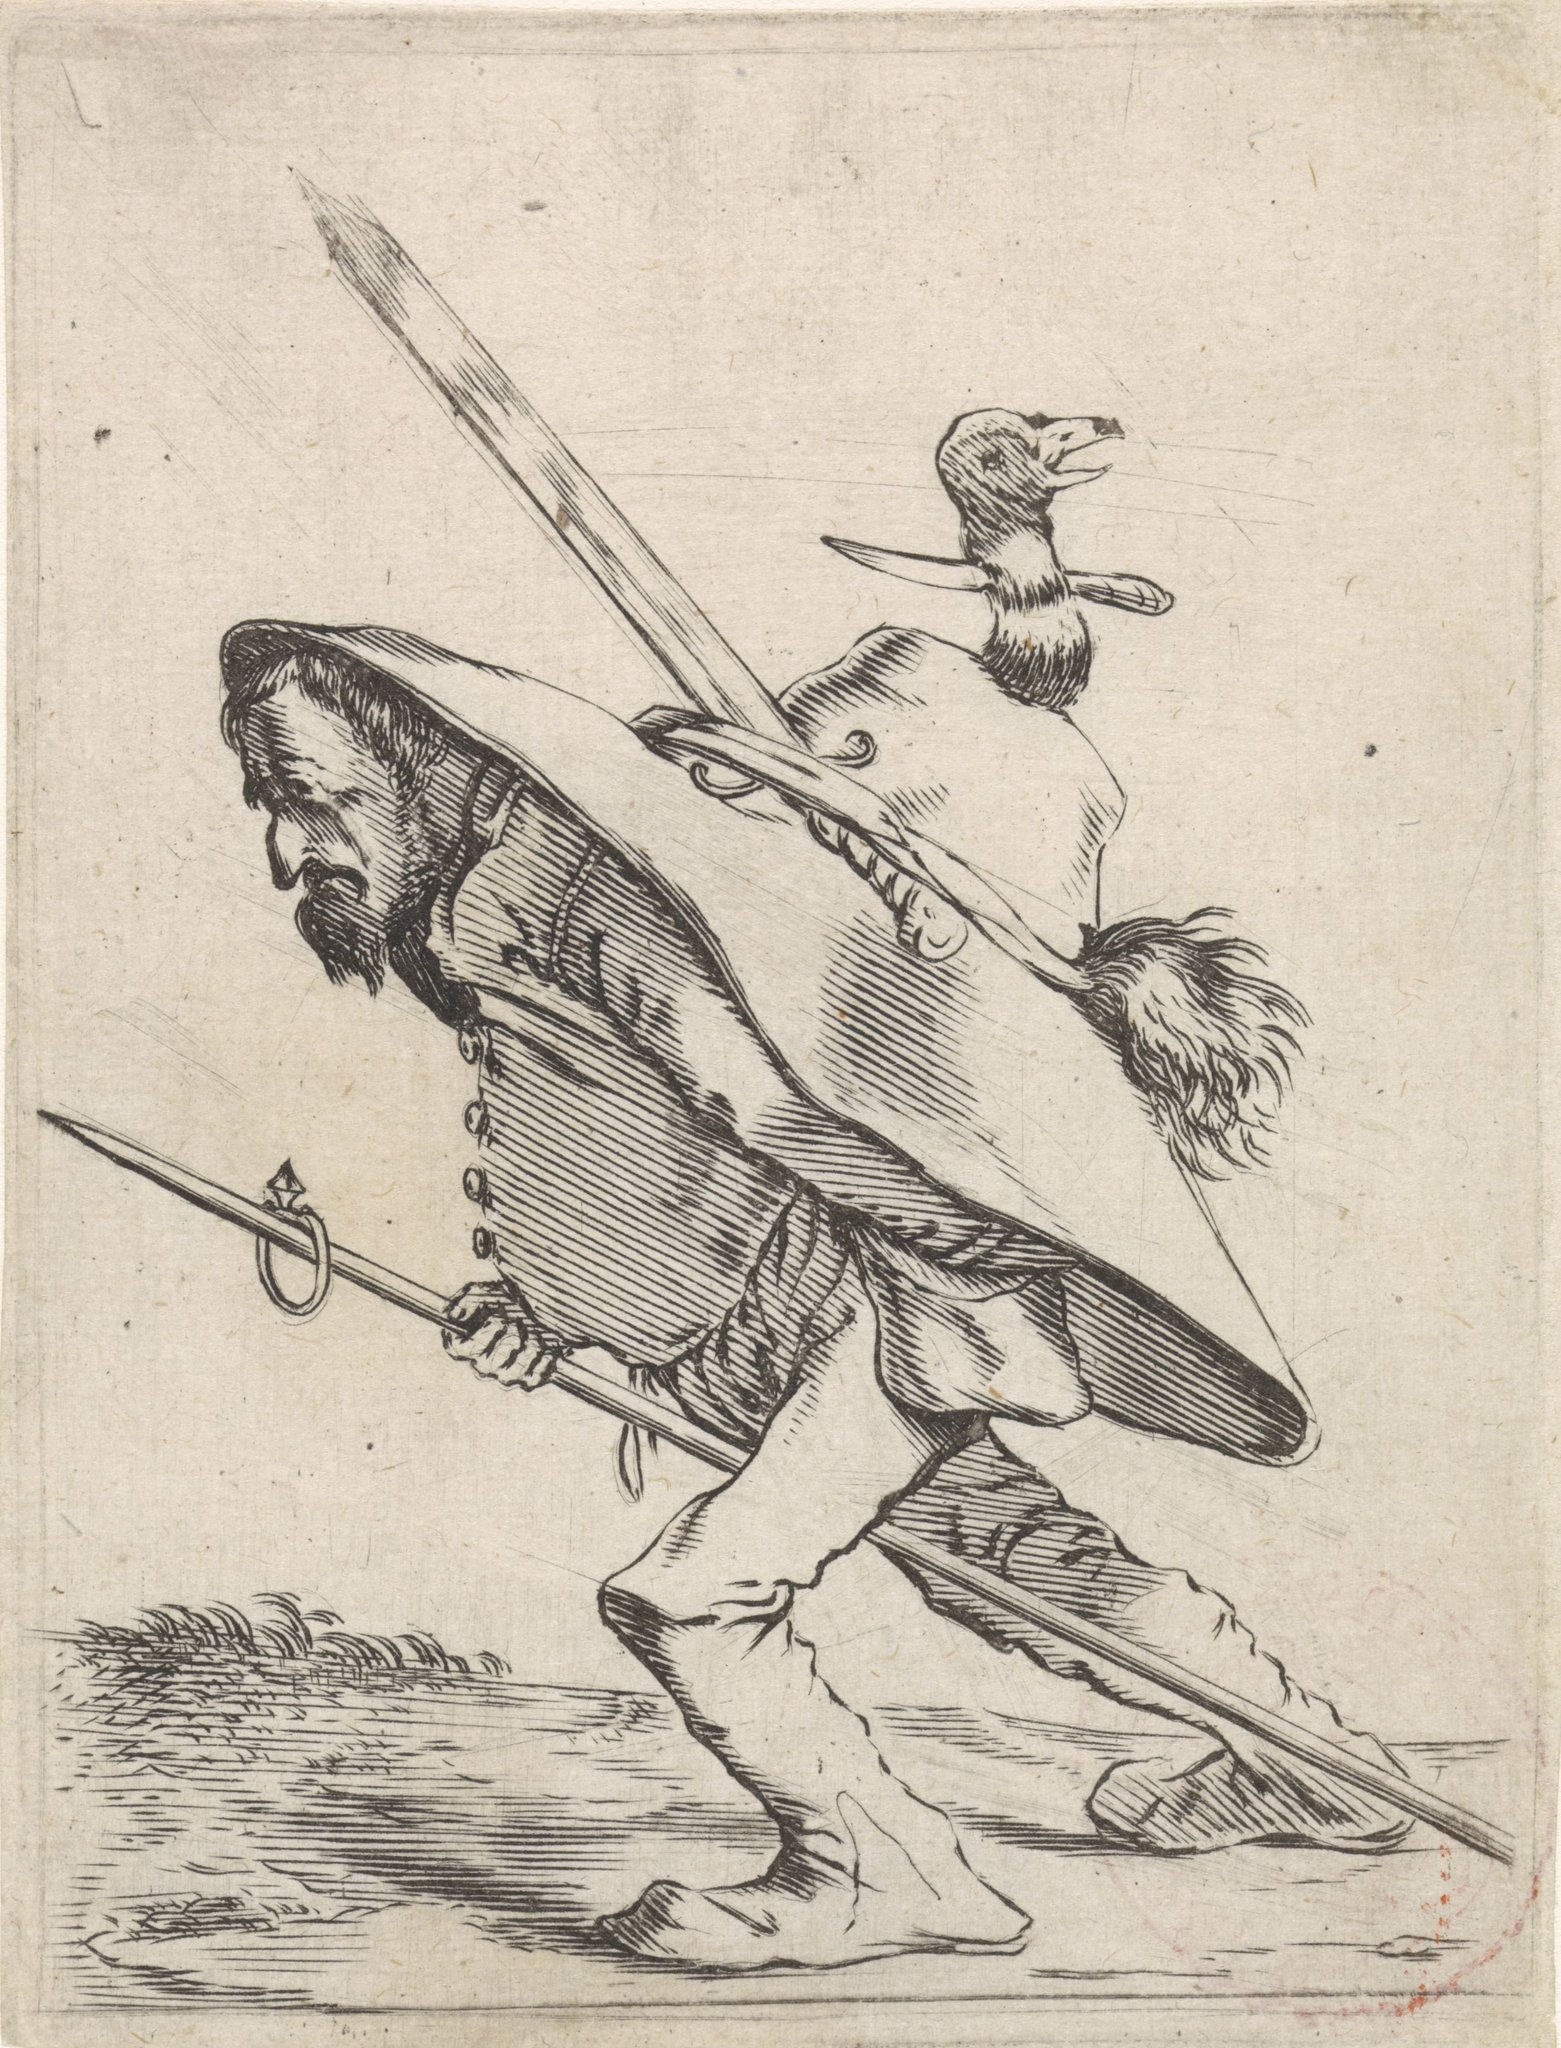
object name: print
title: Vijf zintuigen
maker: cornelis saftleven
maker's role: draughtsman, painter, print maker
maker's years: 1607-1681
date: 1632-1645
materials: paper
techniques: etching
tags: carrying something, birds, head-gear: hat (+ men's clothes), tools, aids, implements ~ crafts and industries: knife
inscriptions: collector's mark: Lugt 240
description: Het gevoel. Een man loopt, gebogen onder het gewicht van de enorme hoed die hij op zijn rug draagt, naar links. Uit de hoed steken de kop en nek van een vogel. De nek van de vogel is doorboord met een mes. De prent maakt deel uit van een serie met de vijf zintuigen.